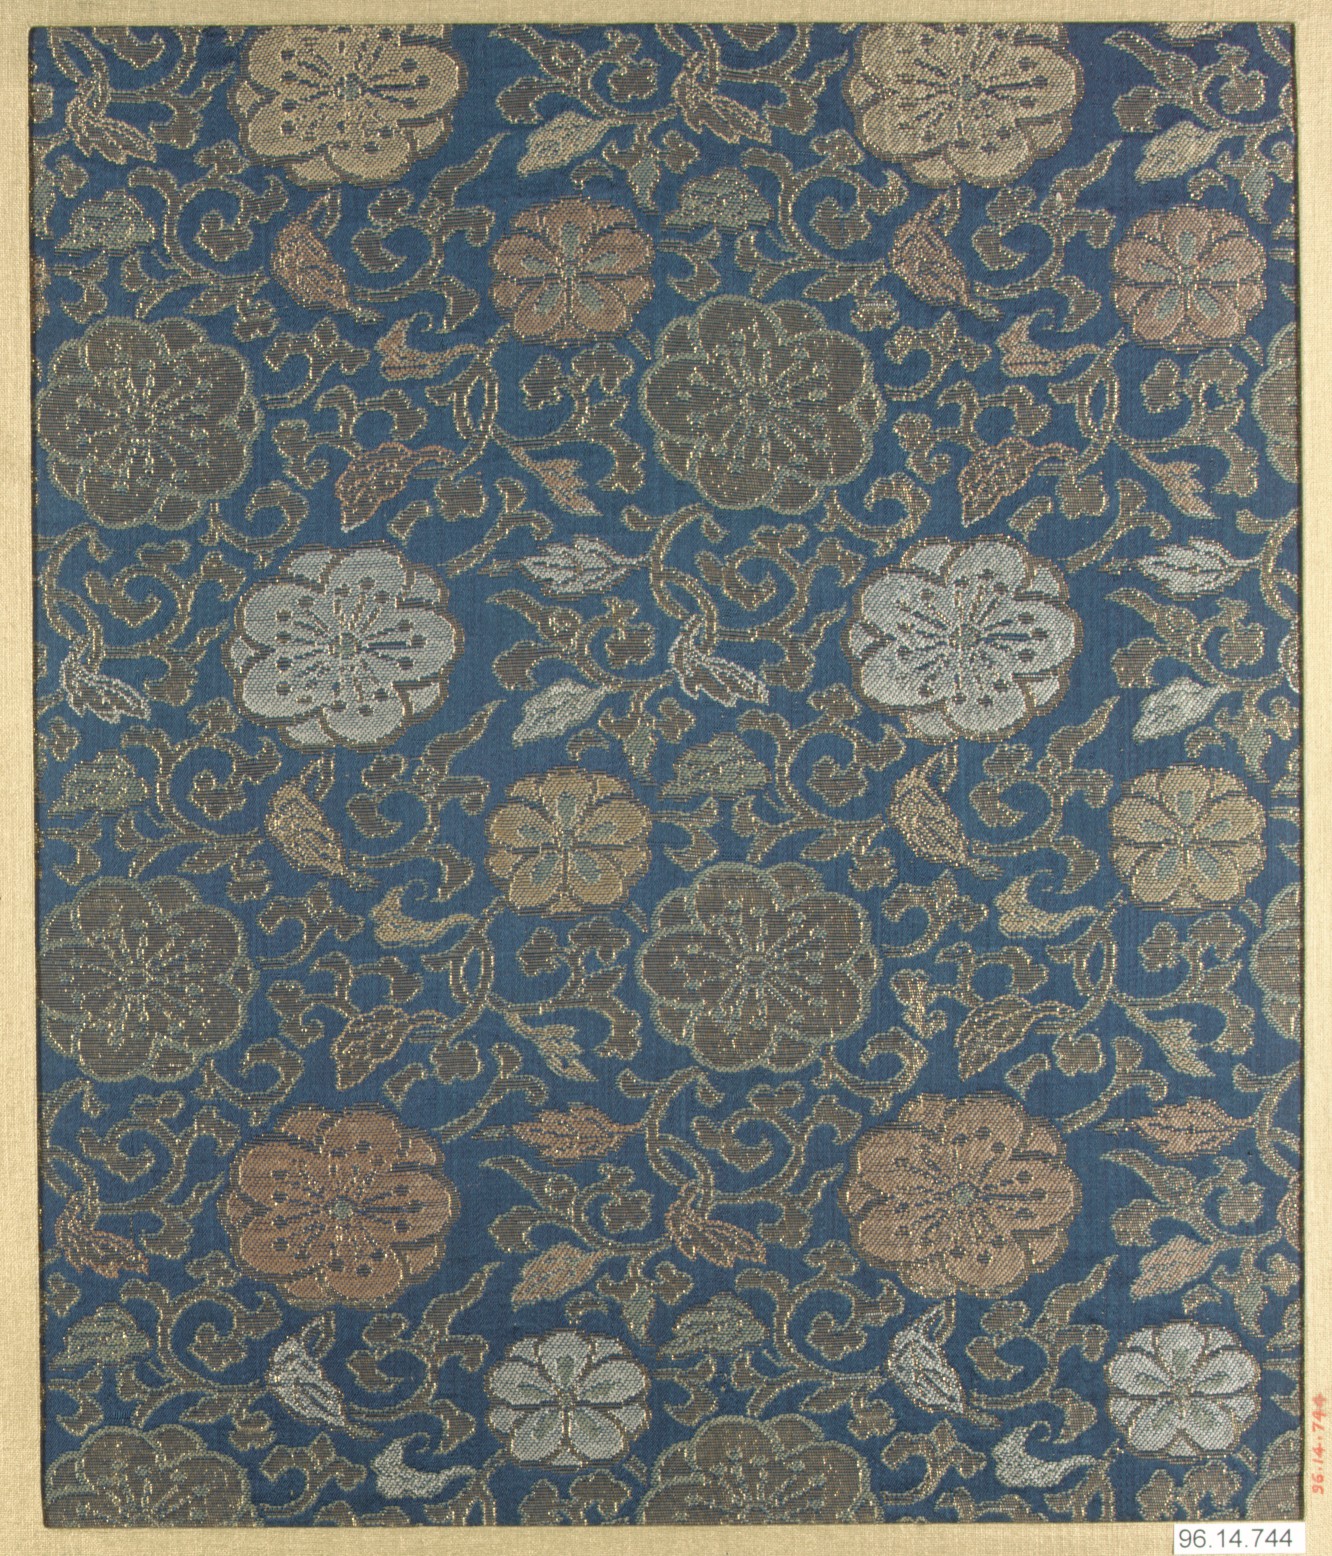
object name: piece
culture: japanese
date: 1701-1900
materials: silk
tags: leaves